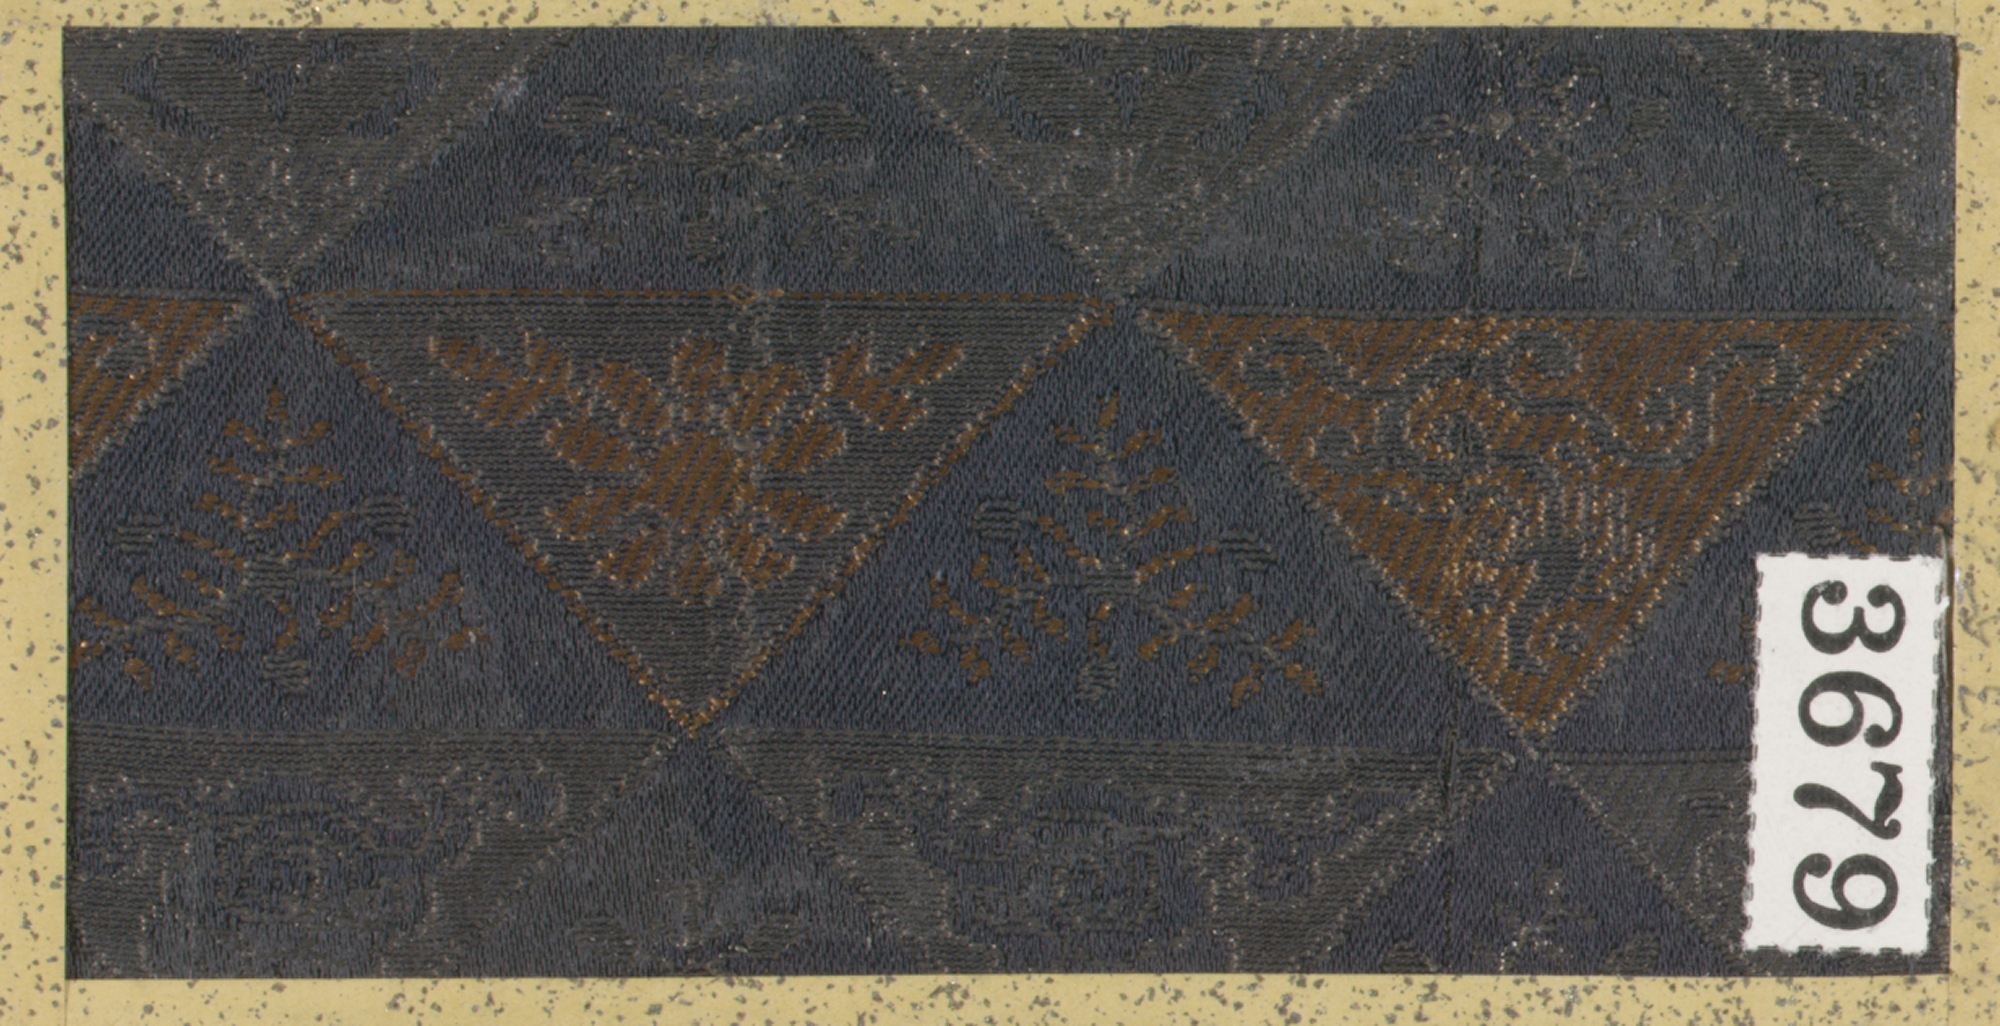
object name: sample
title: Textile Sample from Sample Book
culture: japanese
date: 1801-1900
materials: silk